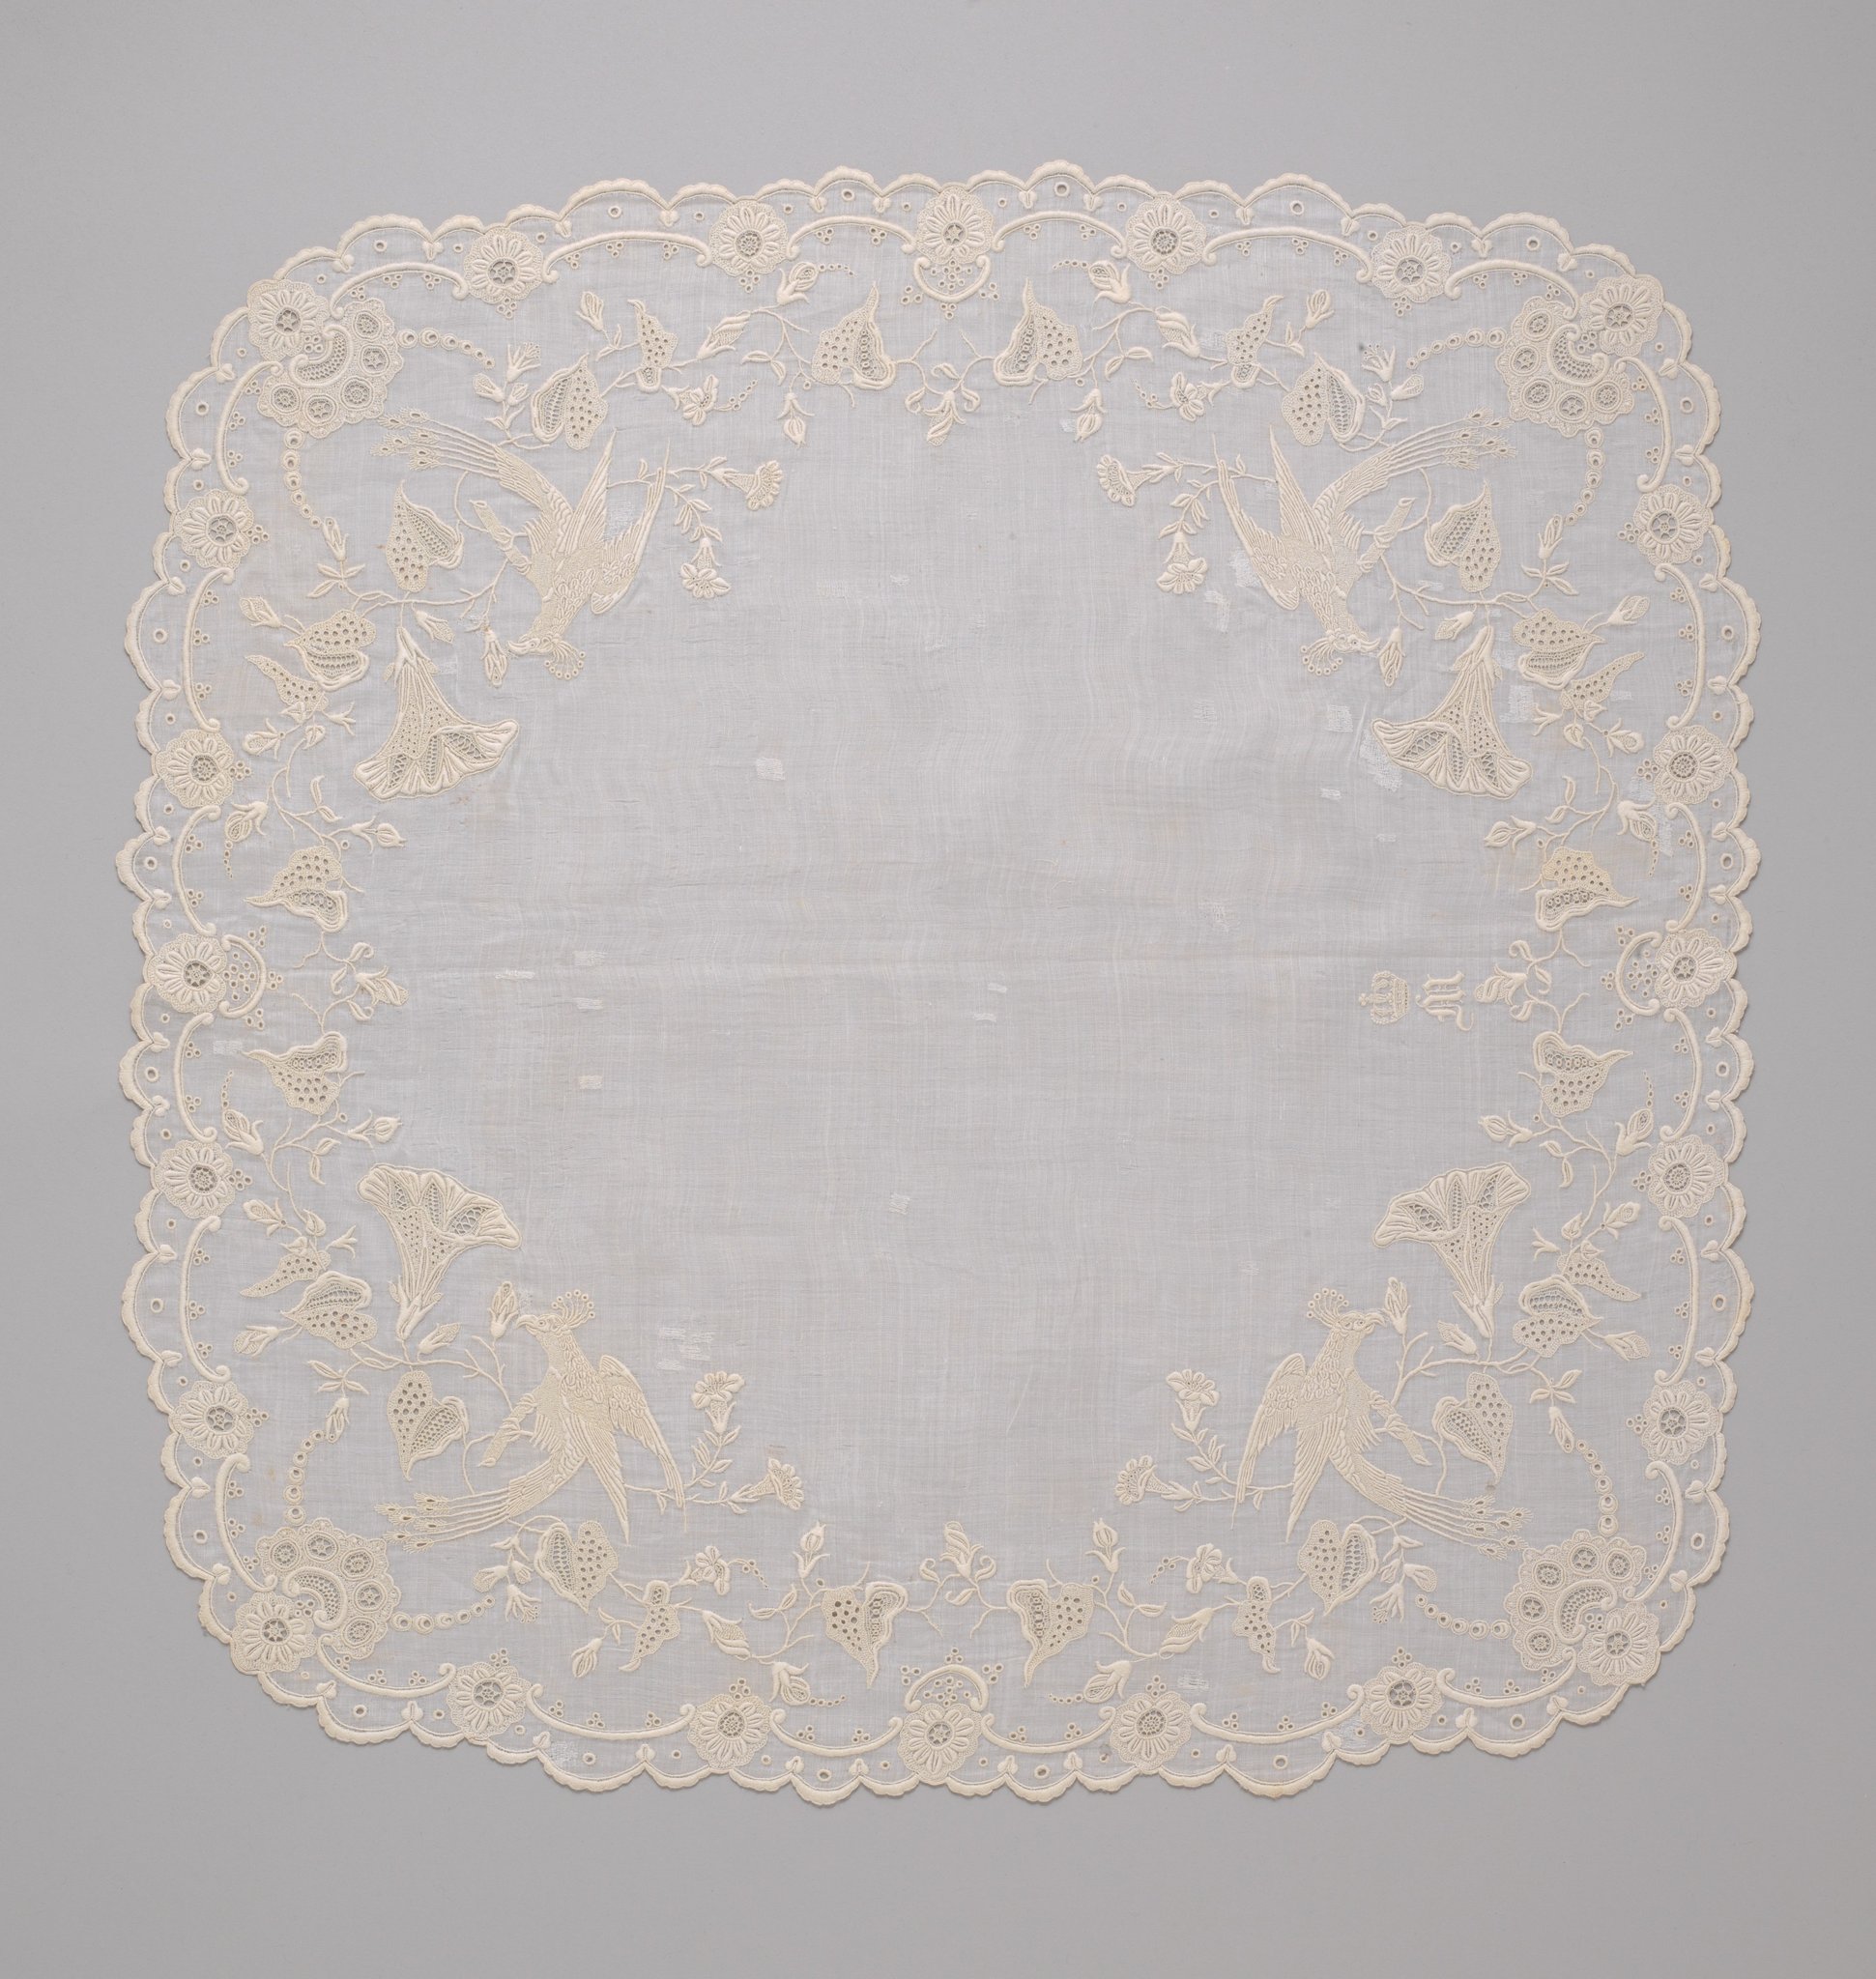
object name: handkerchief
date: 1840-1880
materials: linen, silk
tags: flowers